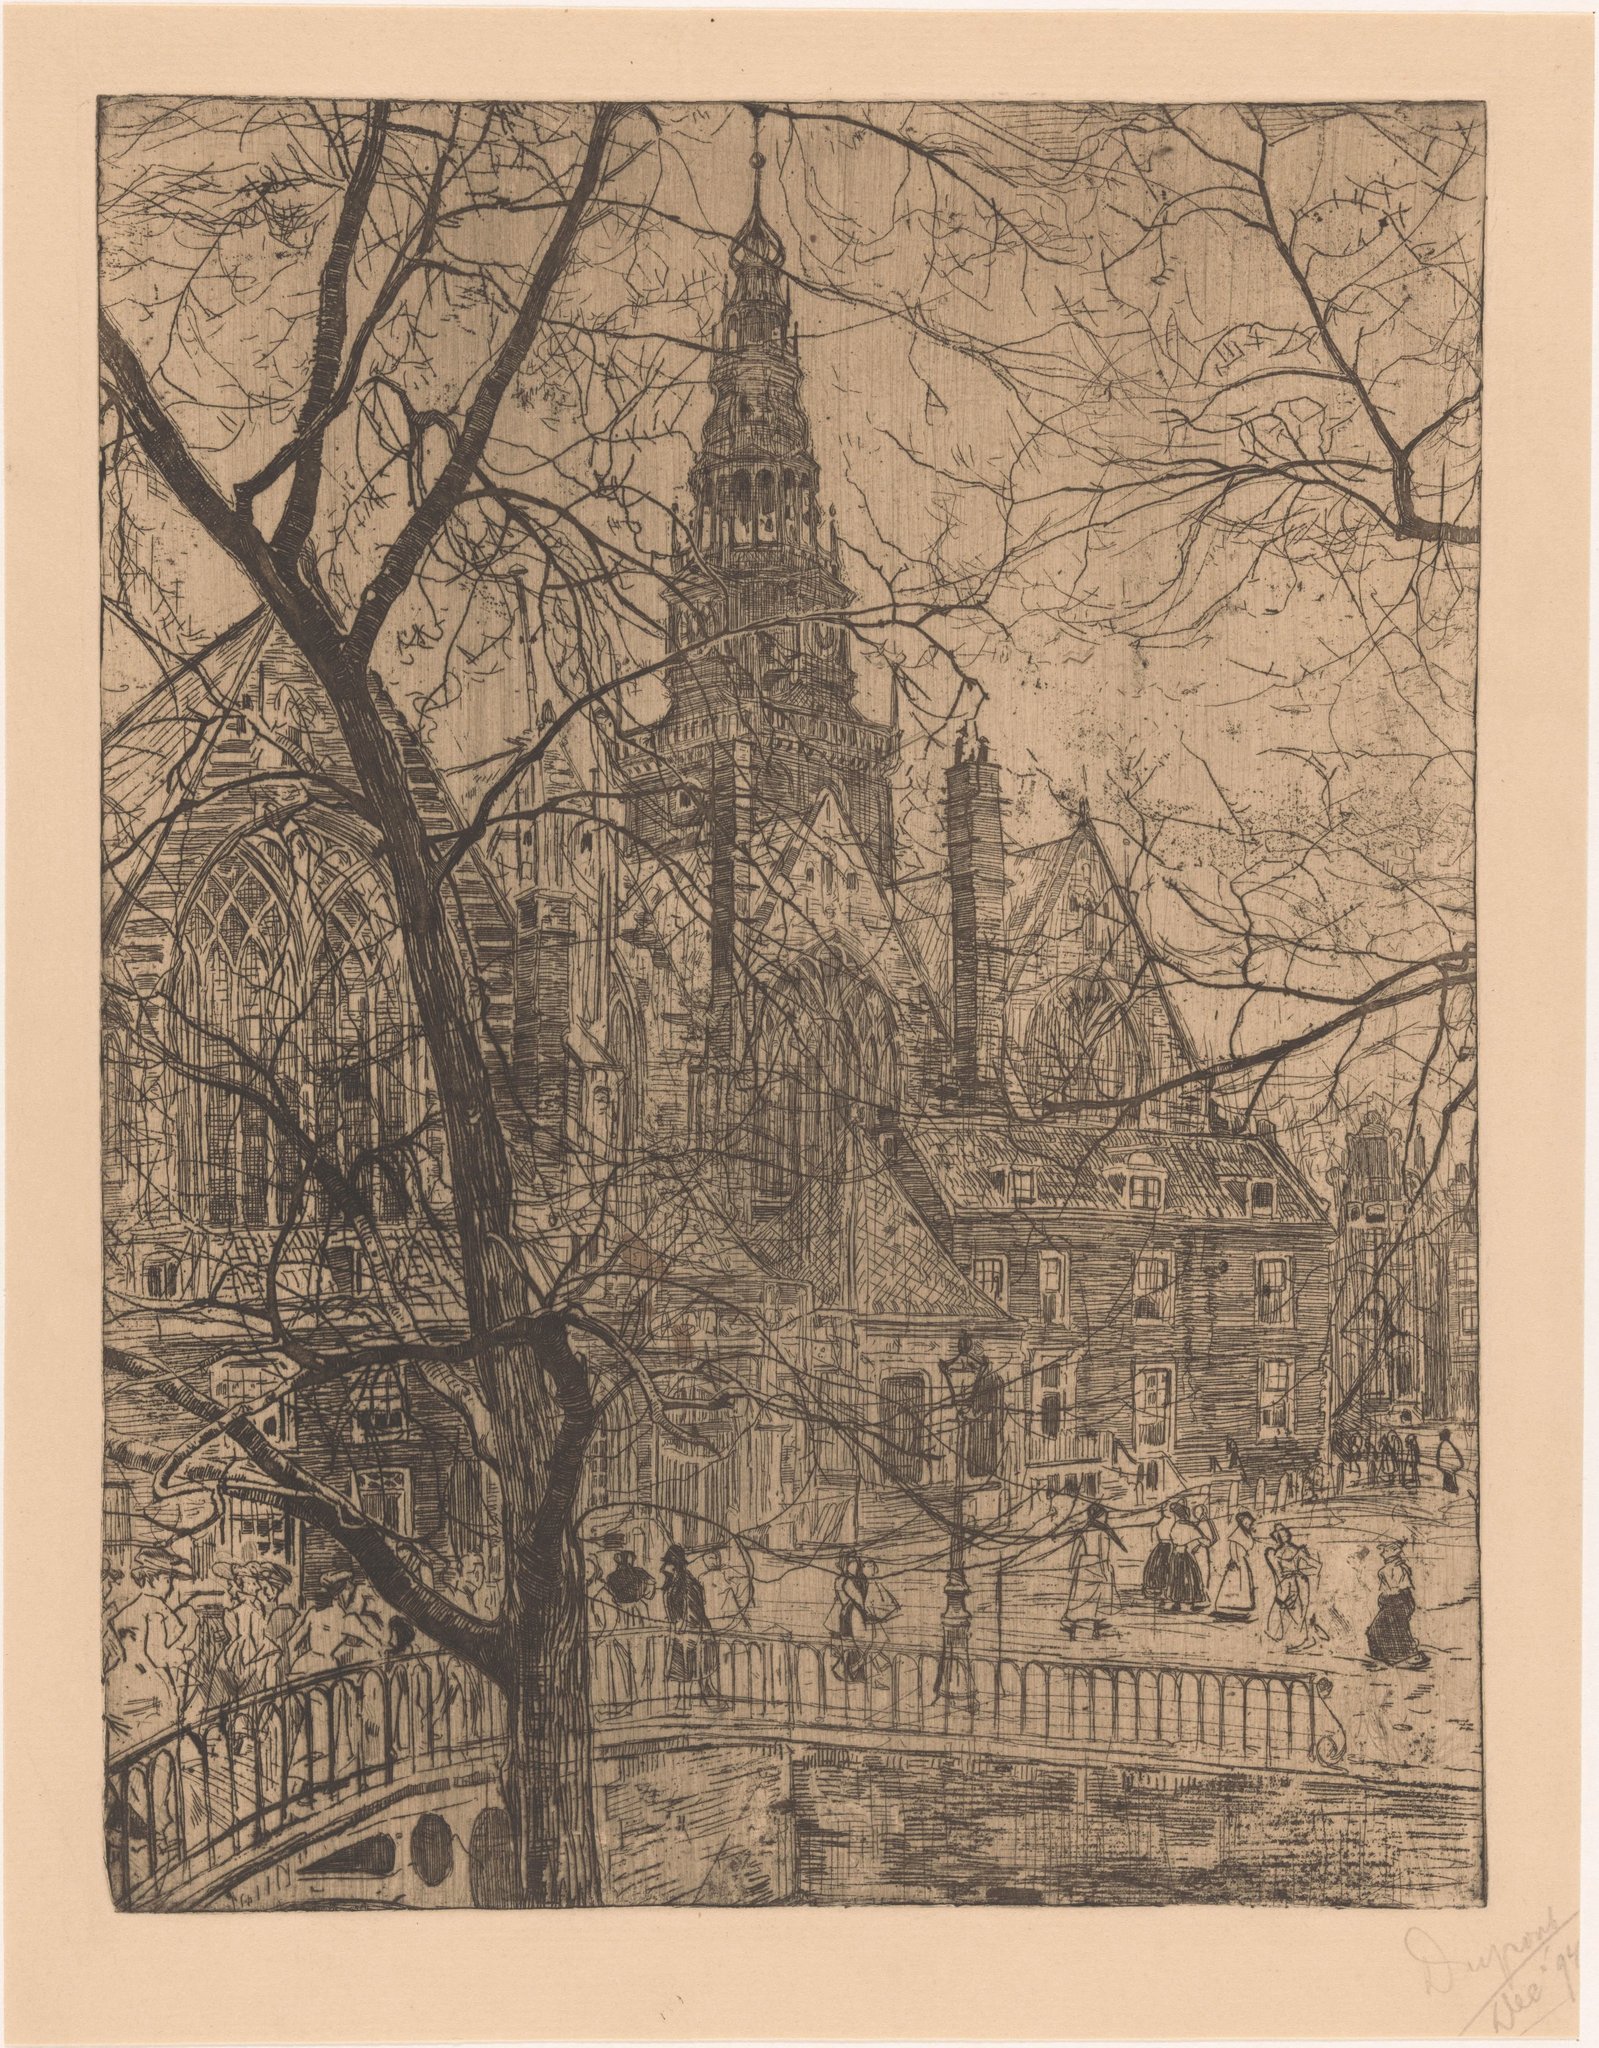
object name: print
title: Oude Kerk in Amsterdam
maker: pieter dupont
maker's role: draughtsman, print maker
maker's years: 1870-1911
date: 1812-1894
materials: paper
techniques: intaglio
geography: amsterdam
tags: square, place, circus, etc., trees (+ bare plant), church (exterior)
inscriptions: collector's mark: Lugt 2228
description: Links op de voorgrond een kale boom. Op het Oudekerksplein wandelende figuren.